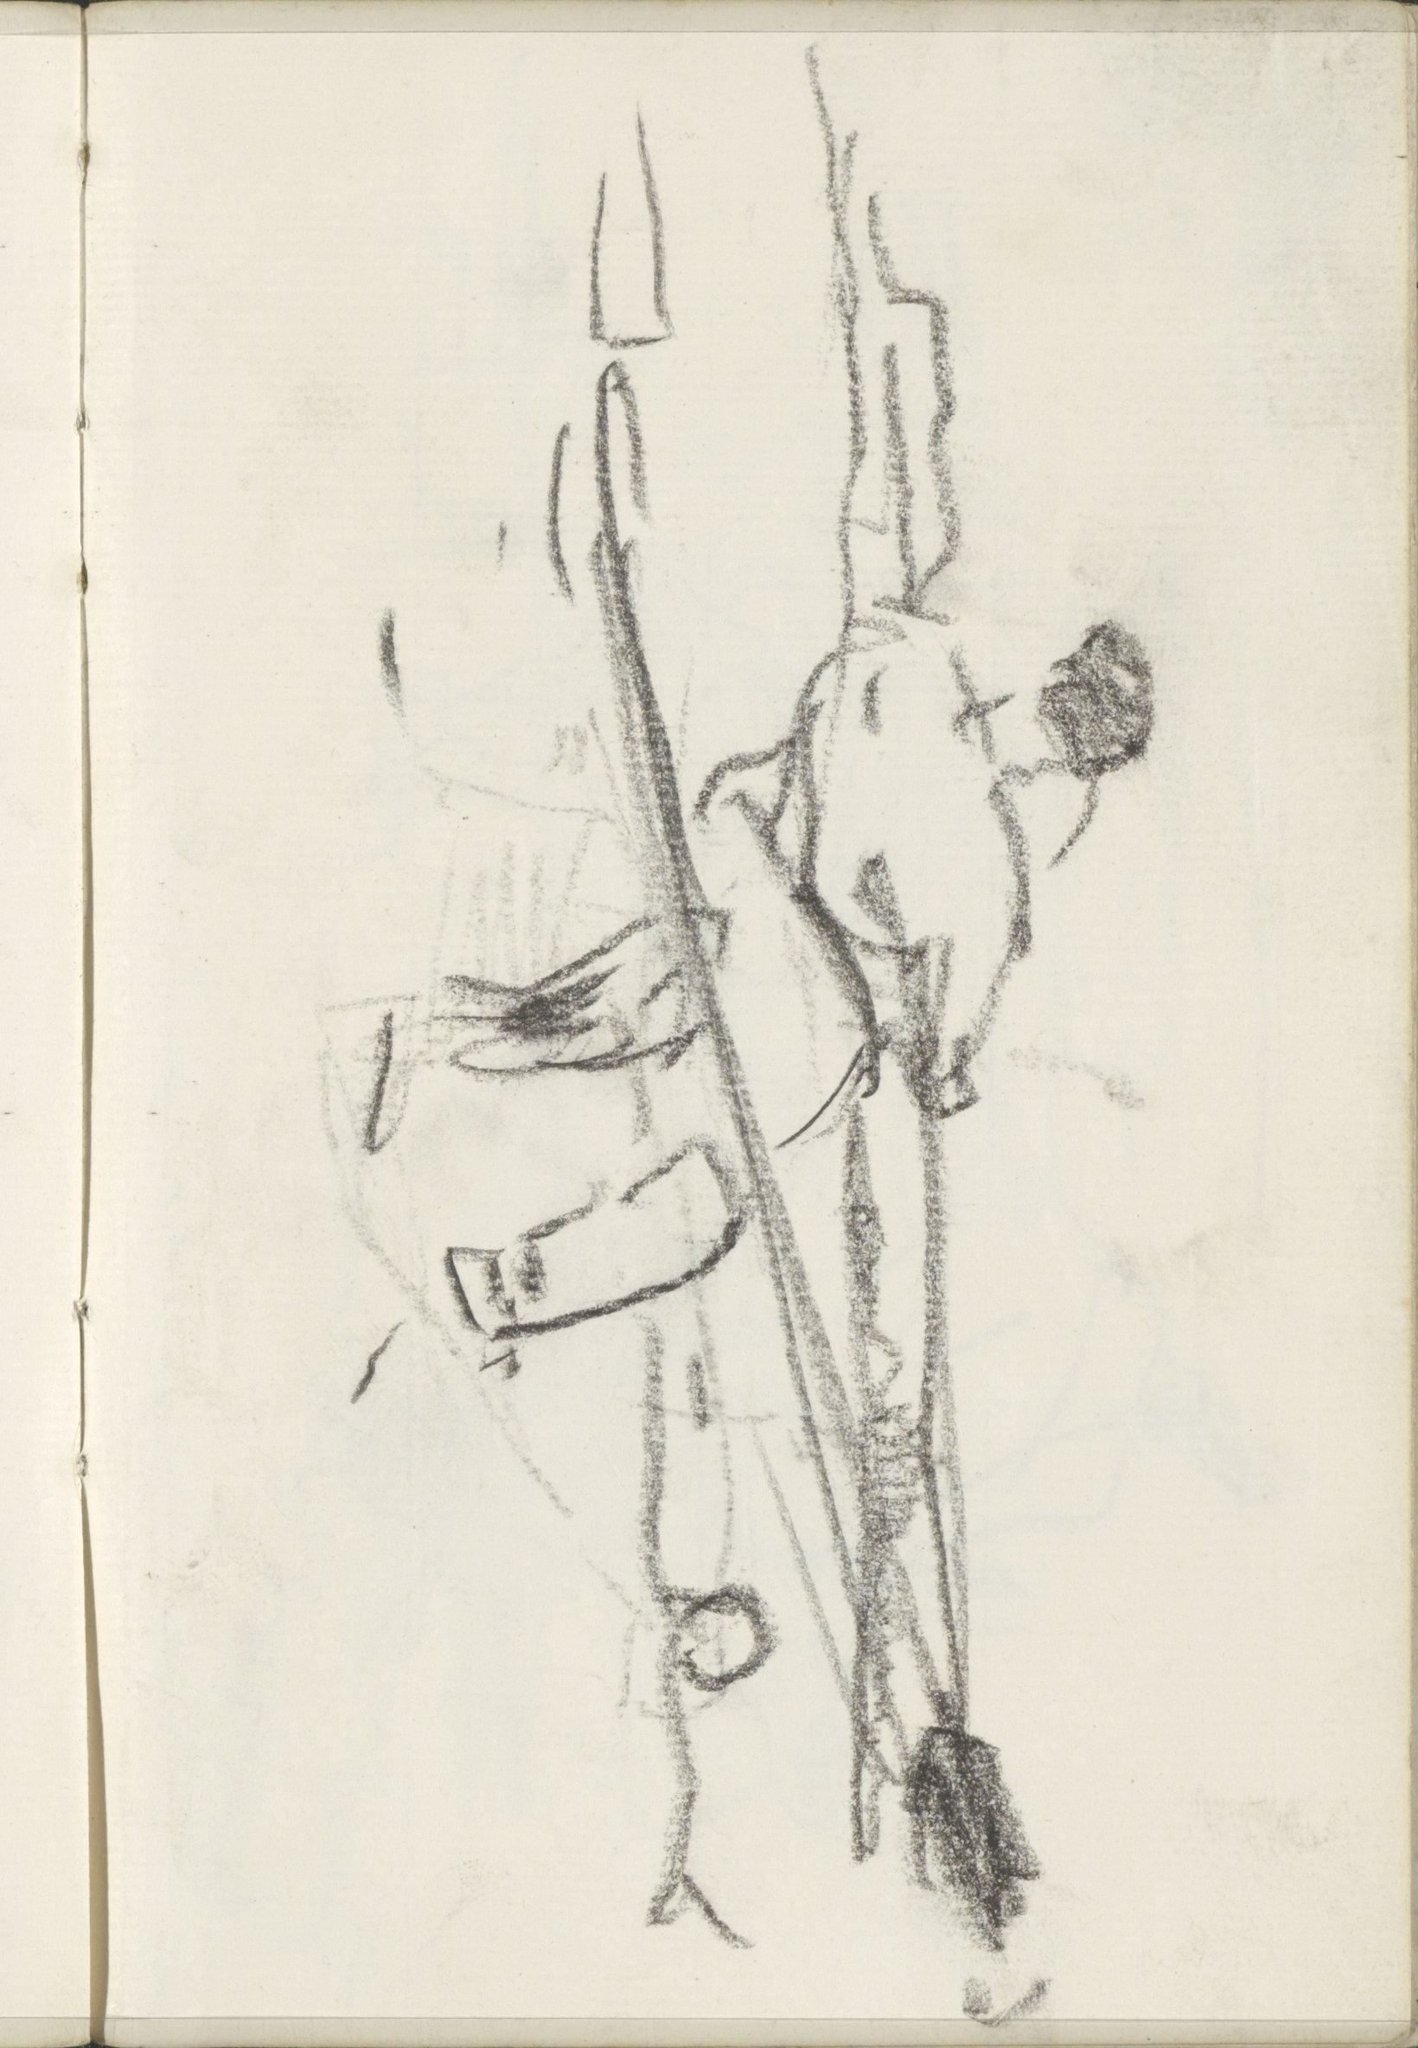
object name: sketchbook leaf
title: Studie, mogelijk van een man op een kade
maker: george hendrik breitner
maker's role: draughtsman, painter, print maker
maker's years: 1857-1923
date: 1895-1898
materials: chalk, paper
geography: amsterdam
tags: adult man, quay, amsterdam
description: Pagina 36 uit een schetsboek met 20 bladen.